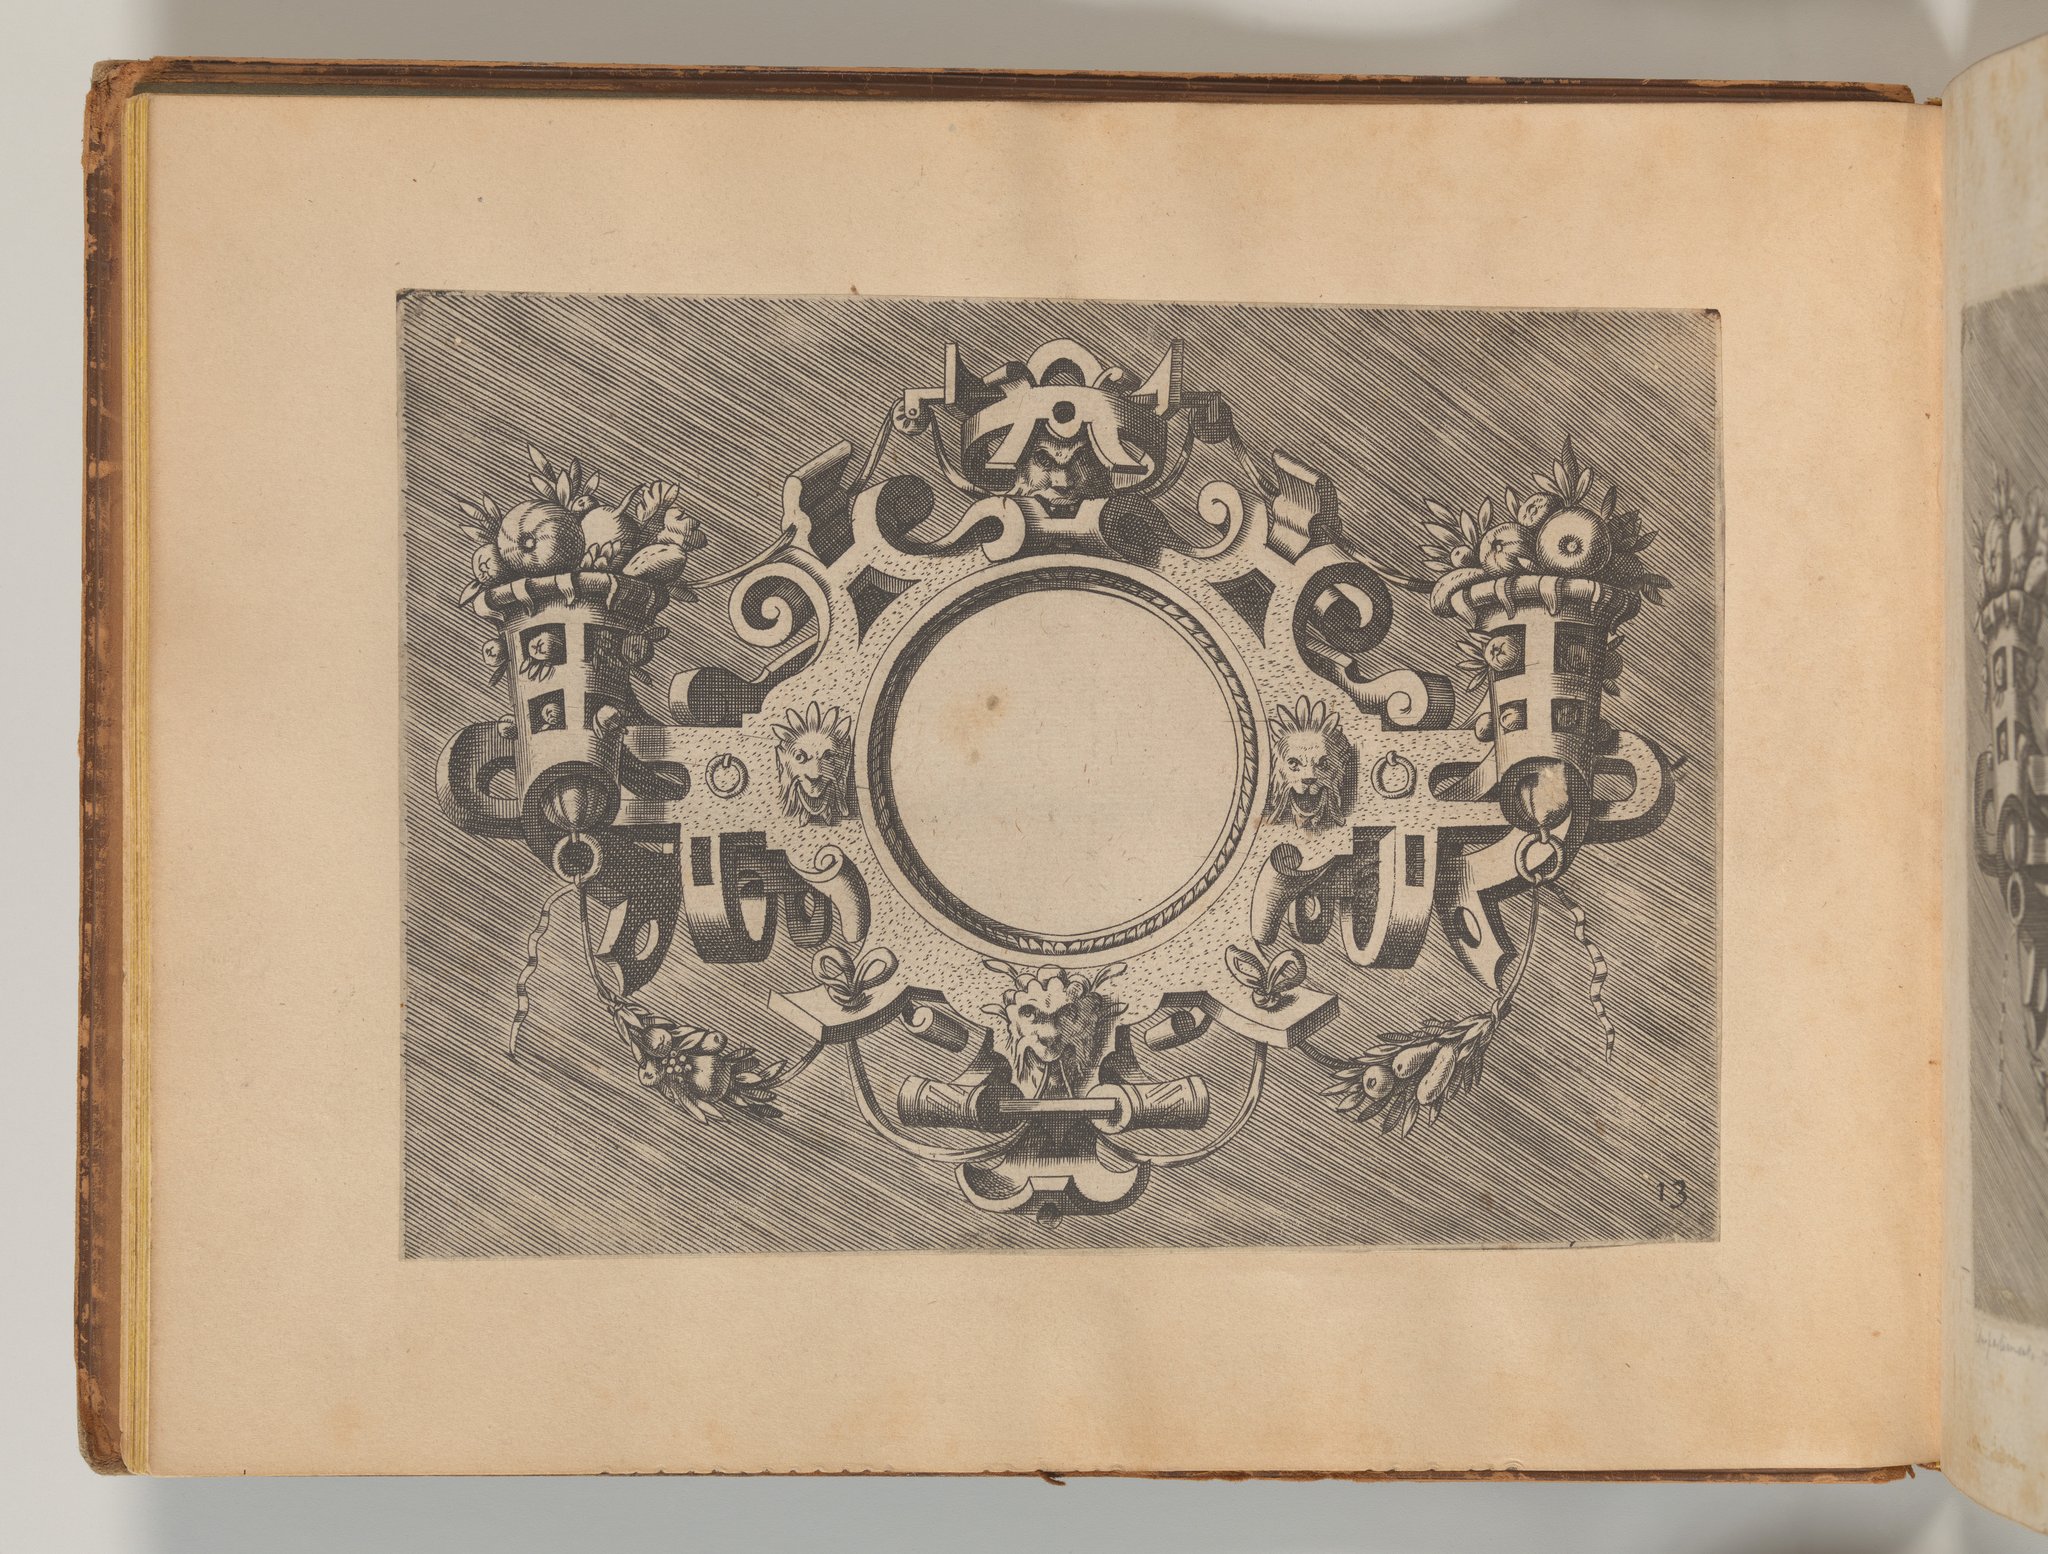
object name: album print ornament architecture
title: Targhe ed altri ornati di varie e capricciose invenzioni (Cartouches and other ornaments of various and capricious invention, page 17)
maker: hans vredeman de vries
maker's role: artist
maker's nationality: netherlandish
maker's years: 1527-1606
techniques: engraving, etching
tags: cartouches,ornament